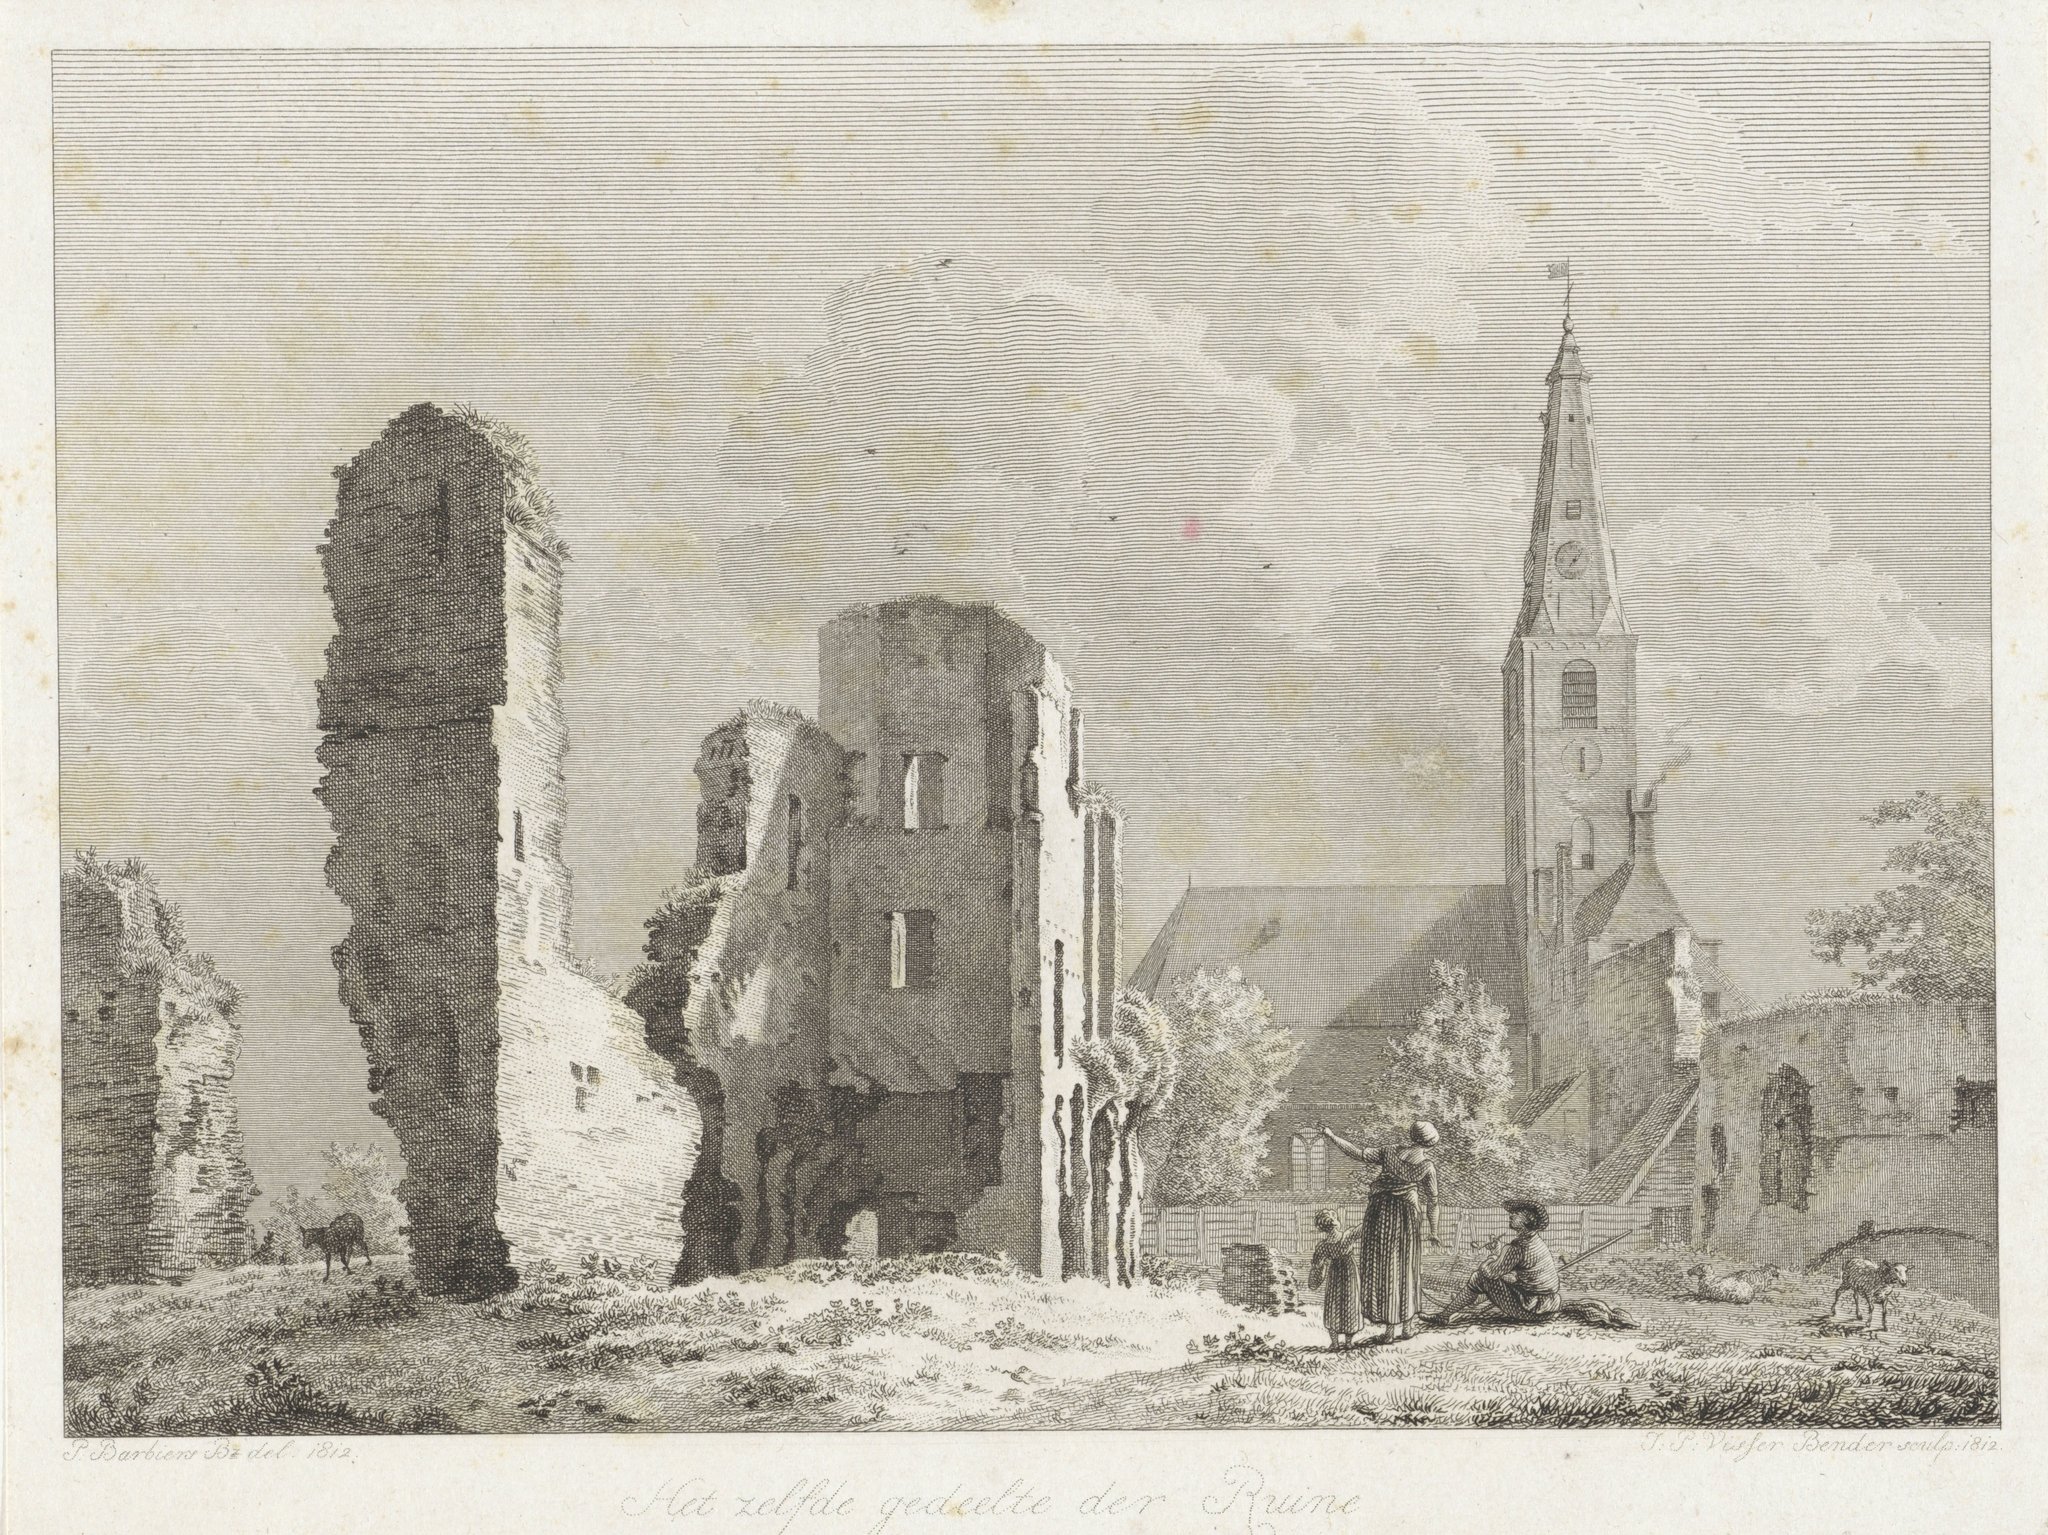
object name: print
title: Het zelfde gedeelte der Ruine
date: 1812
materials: paper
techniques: engraving, etching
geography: haarlem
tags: ruin of church, monastery, etc.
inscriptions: collector's mark: Lugt 2228, collector's mark: Lugt 2760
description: Gezicht op de ruïne van de abdij te Rijnsburg. Op de voorgrond is een vrouw met een kind in gesprek met een zittende boer, met een pijp in de hand en naast zich een zeis.